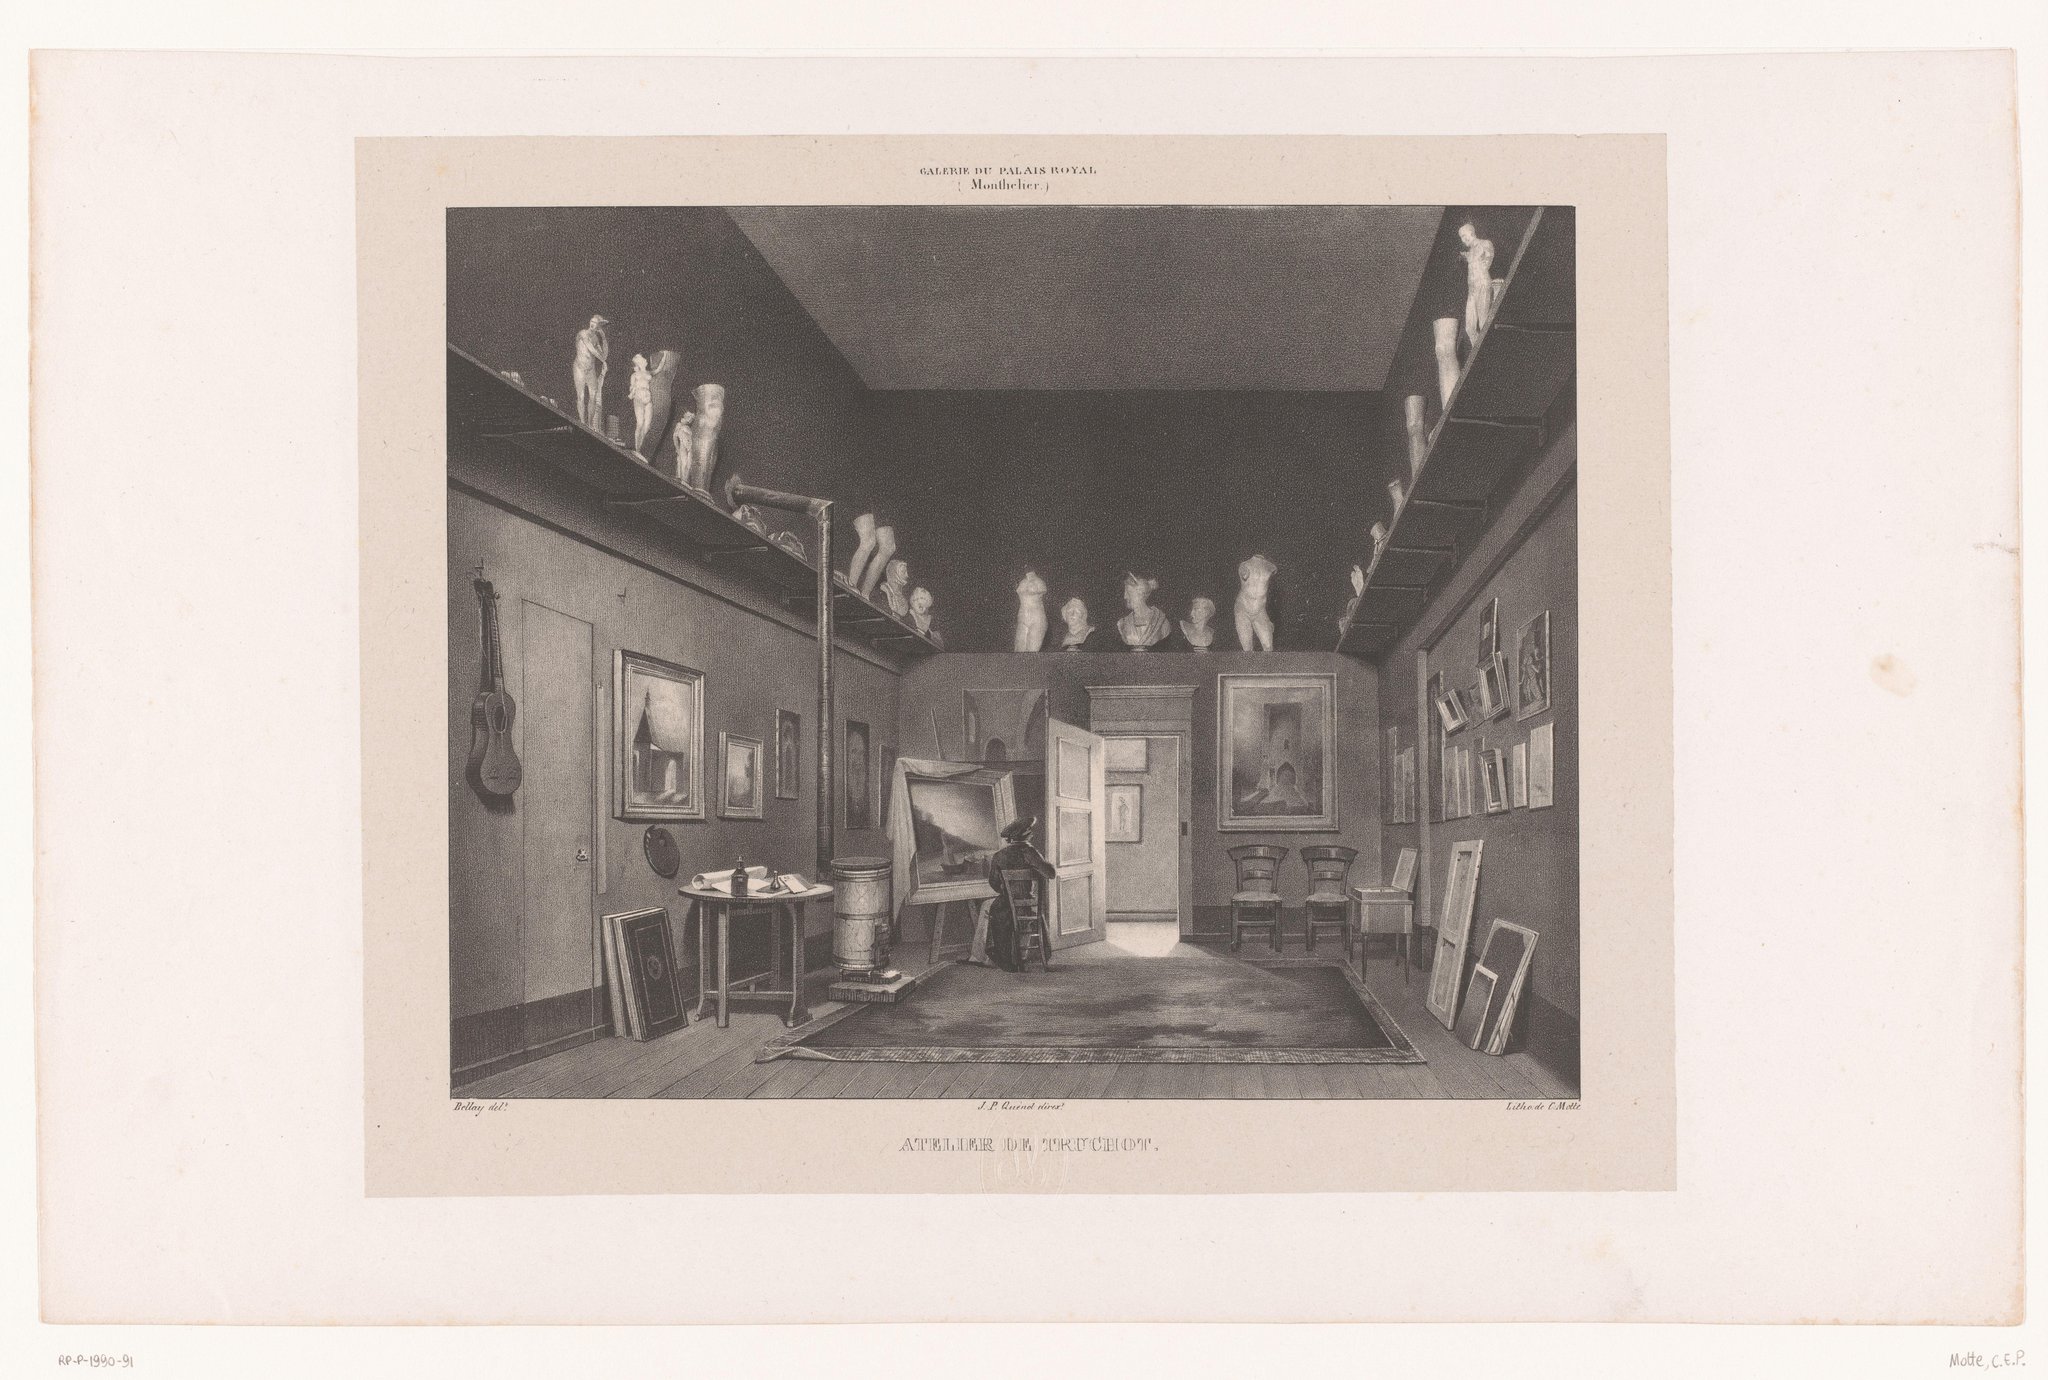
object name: print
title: Galerie lithographiée de S.A.R. Mgr le duc d'Orléans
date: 1824-1829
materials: paper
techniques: lithograph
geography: paris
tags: henri édouard truchot, workshop, studio ~ painter, sculpture, picture, painting, working situations ~ painter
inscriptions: collector's mark: Lugt 2228, check stamp: Lugt 1999d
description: Onderdeel van een prentserie over de schilderijenverzameling van Lodewijk Filips, hertog van Orléans - de latere koning Lodewijk Filips I.